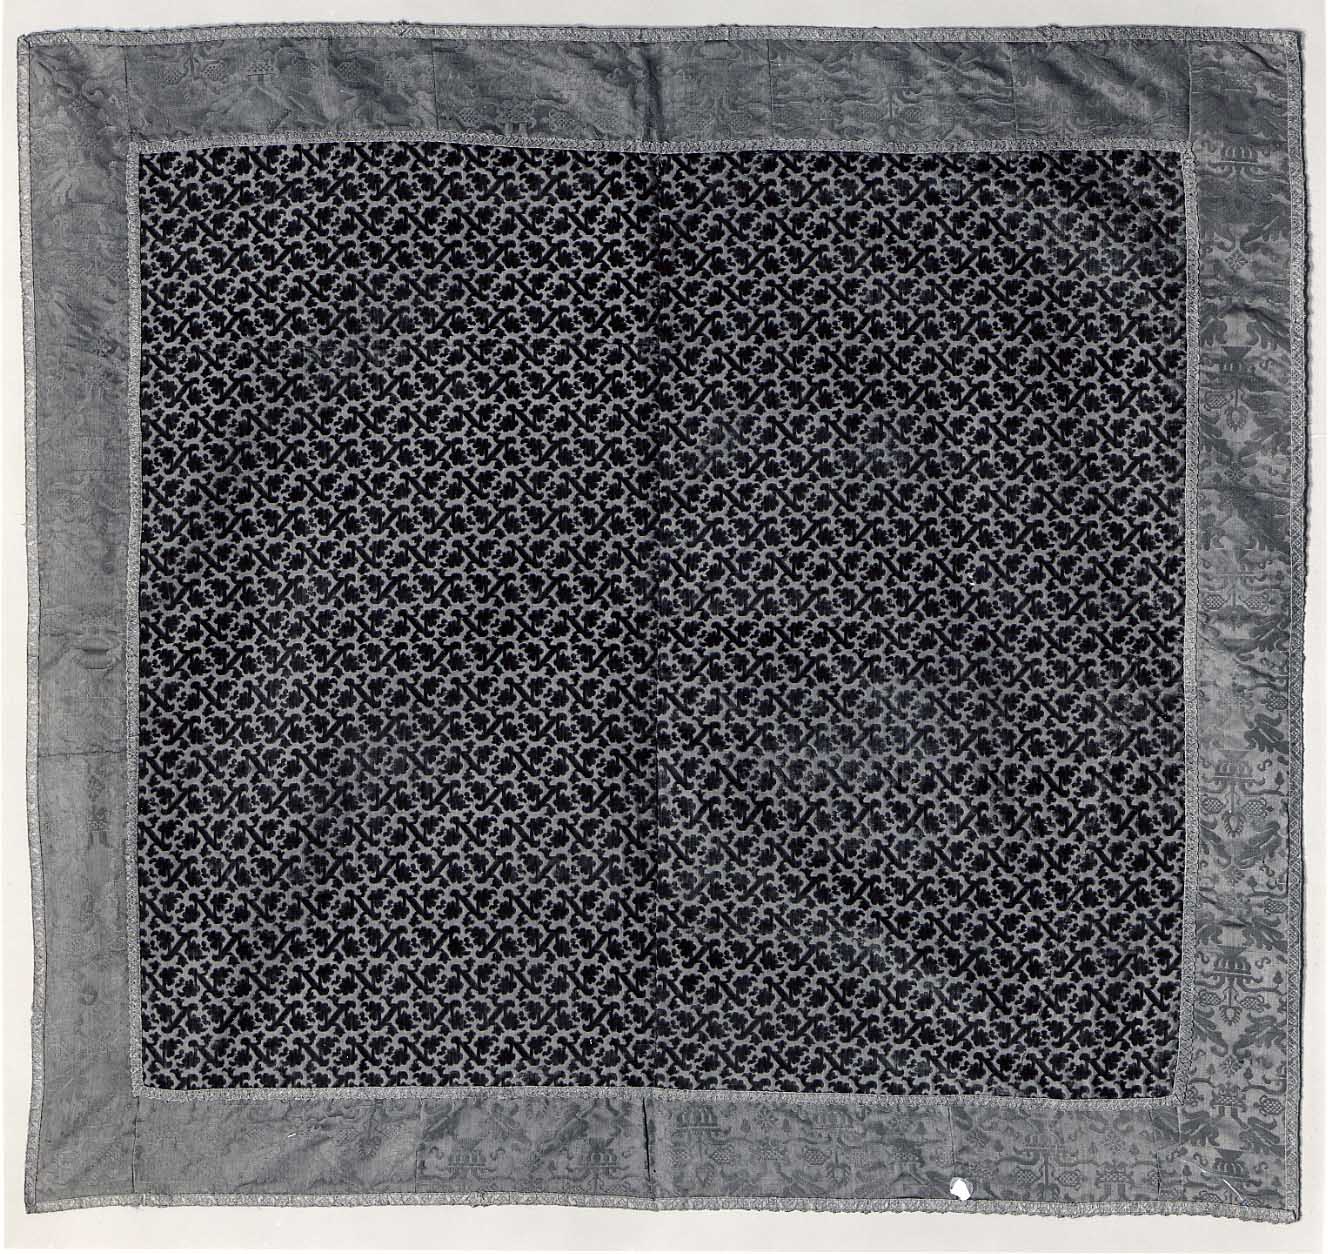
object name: textile cover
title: Cover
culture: italian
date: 1567-1633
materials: metal, silk